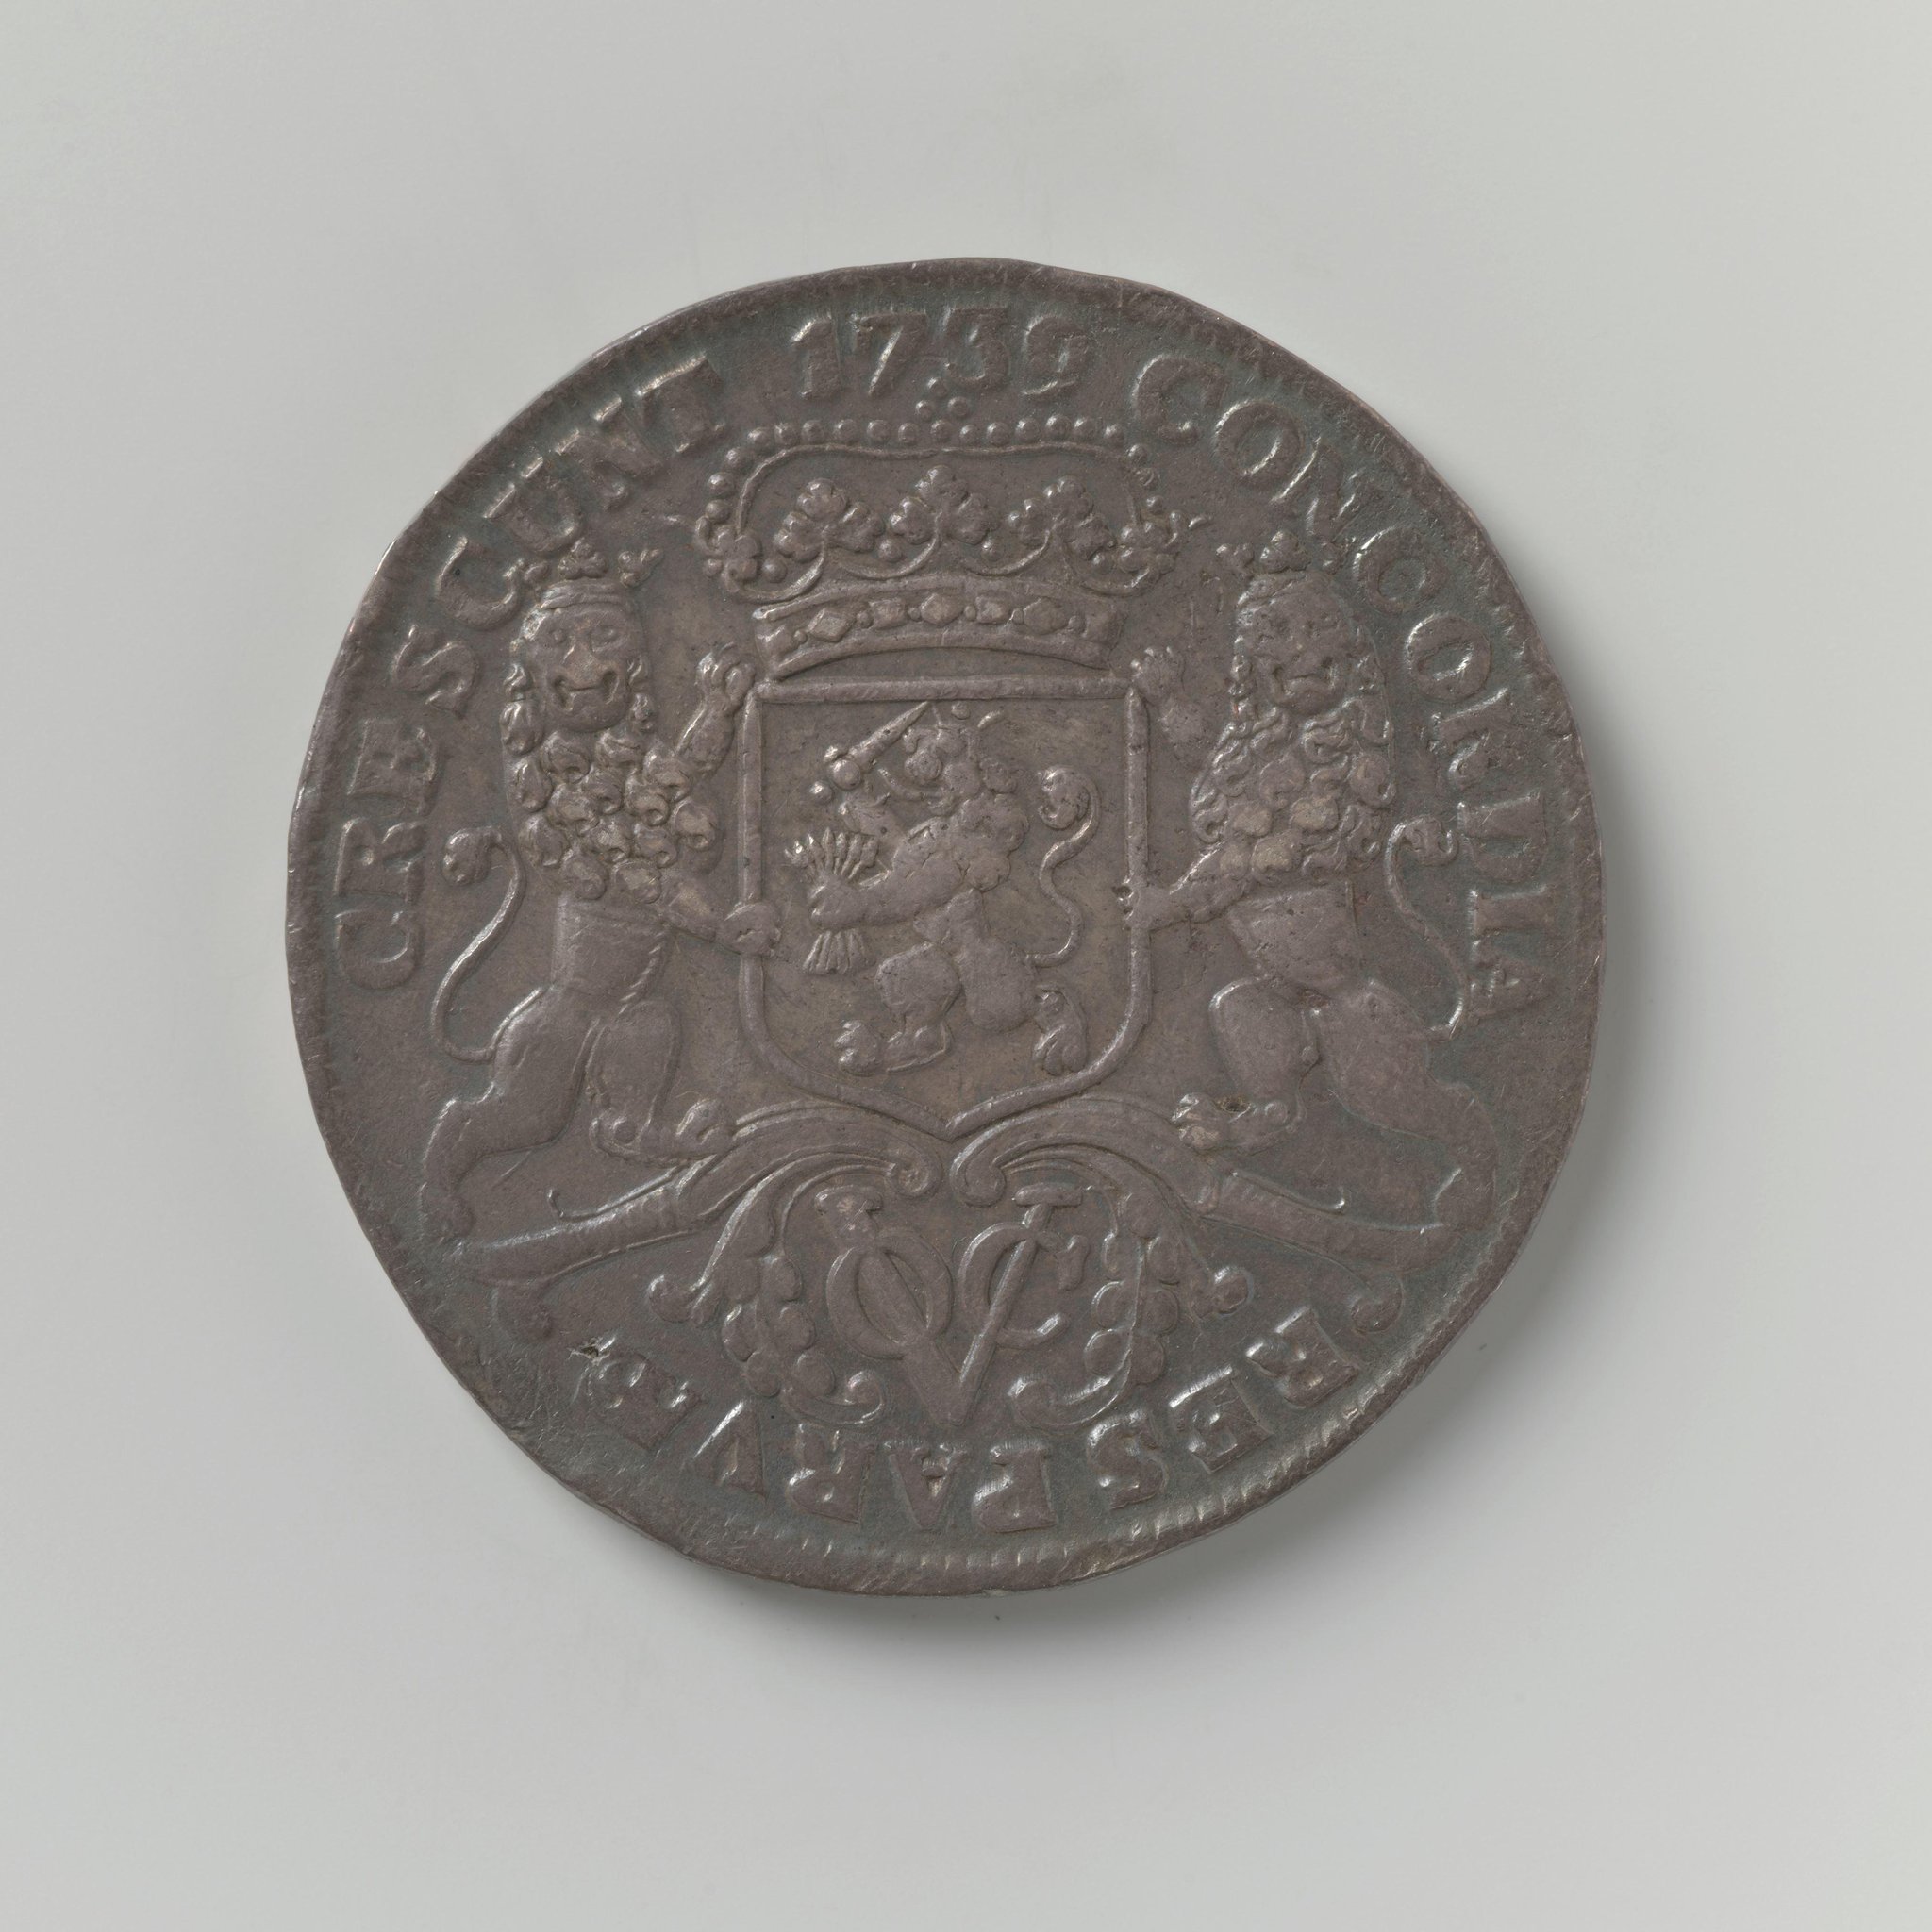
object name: coin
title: VOC, zilveren rijder, Westfriesland, 1739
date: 1739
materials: silver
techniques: striking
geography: enkhuizen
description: Zilveren munt. Voorzijde: geharnaste ridder met zwaard te paard naar links, waaronder gekroond wapenschild van Westfriesland. Keerzijde: gekroond generaliteitswapenschild, waaronder cartouche, waarin monogram van de VOC. Jaartal in omschrift, boven kroon. Gladde rand.